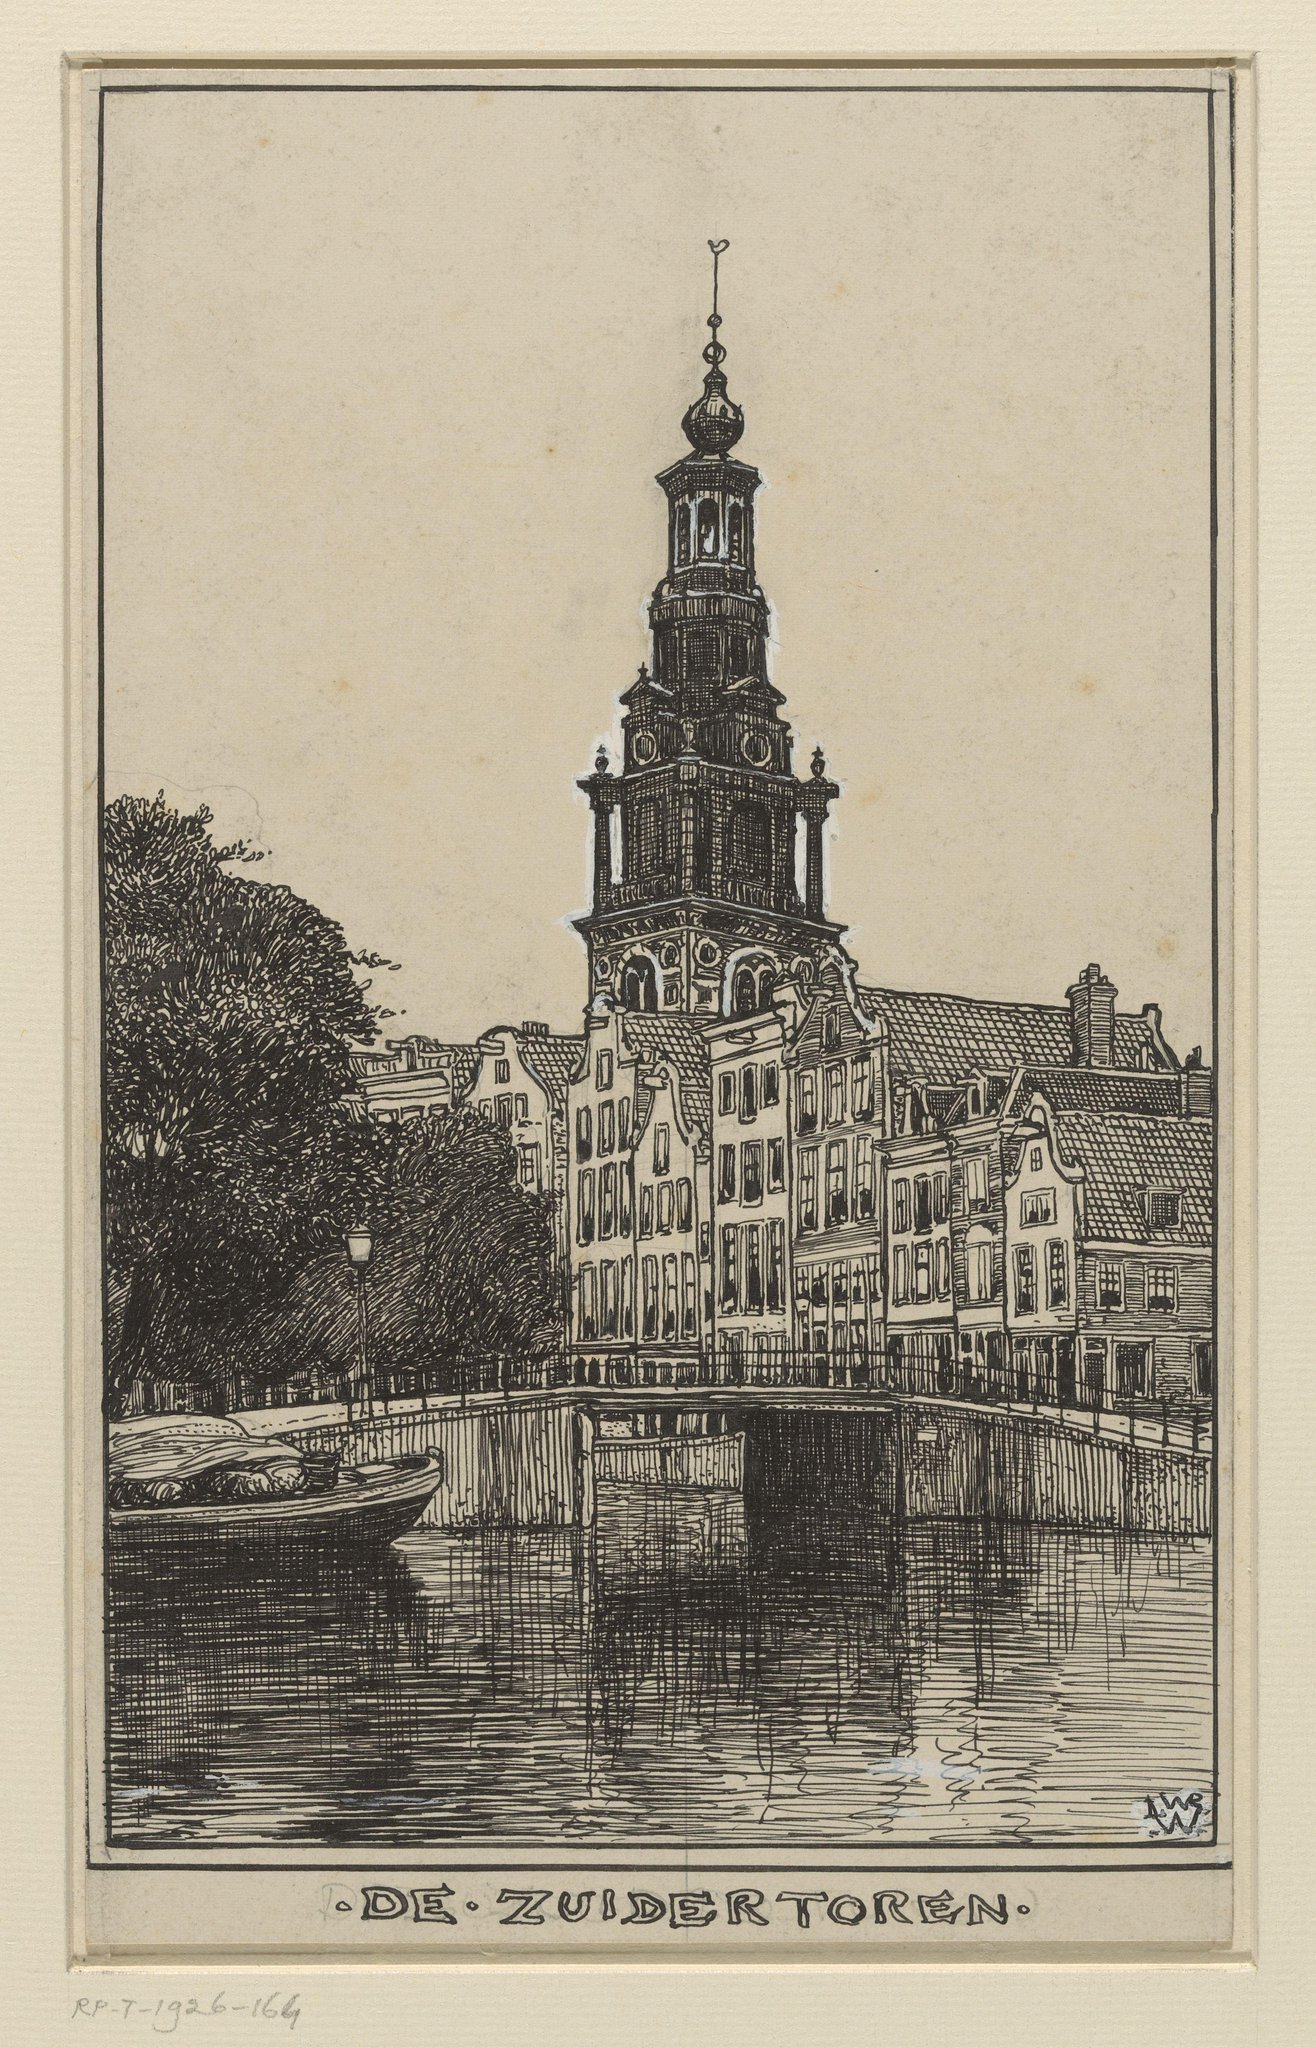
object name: drawing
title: De Zuidertoren te Amsterdam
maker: willem wenckebach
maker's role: designer, draughtsman, painter, print maker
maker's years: 1860-1937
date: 1870-1926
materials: cardboard, paint, ink, pencil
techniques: pen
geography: amsterdam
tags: city-view in general; 'veduta', church (exterior), amsterdam